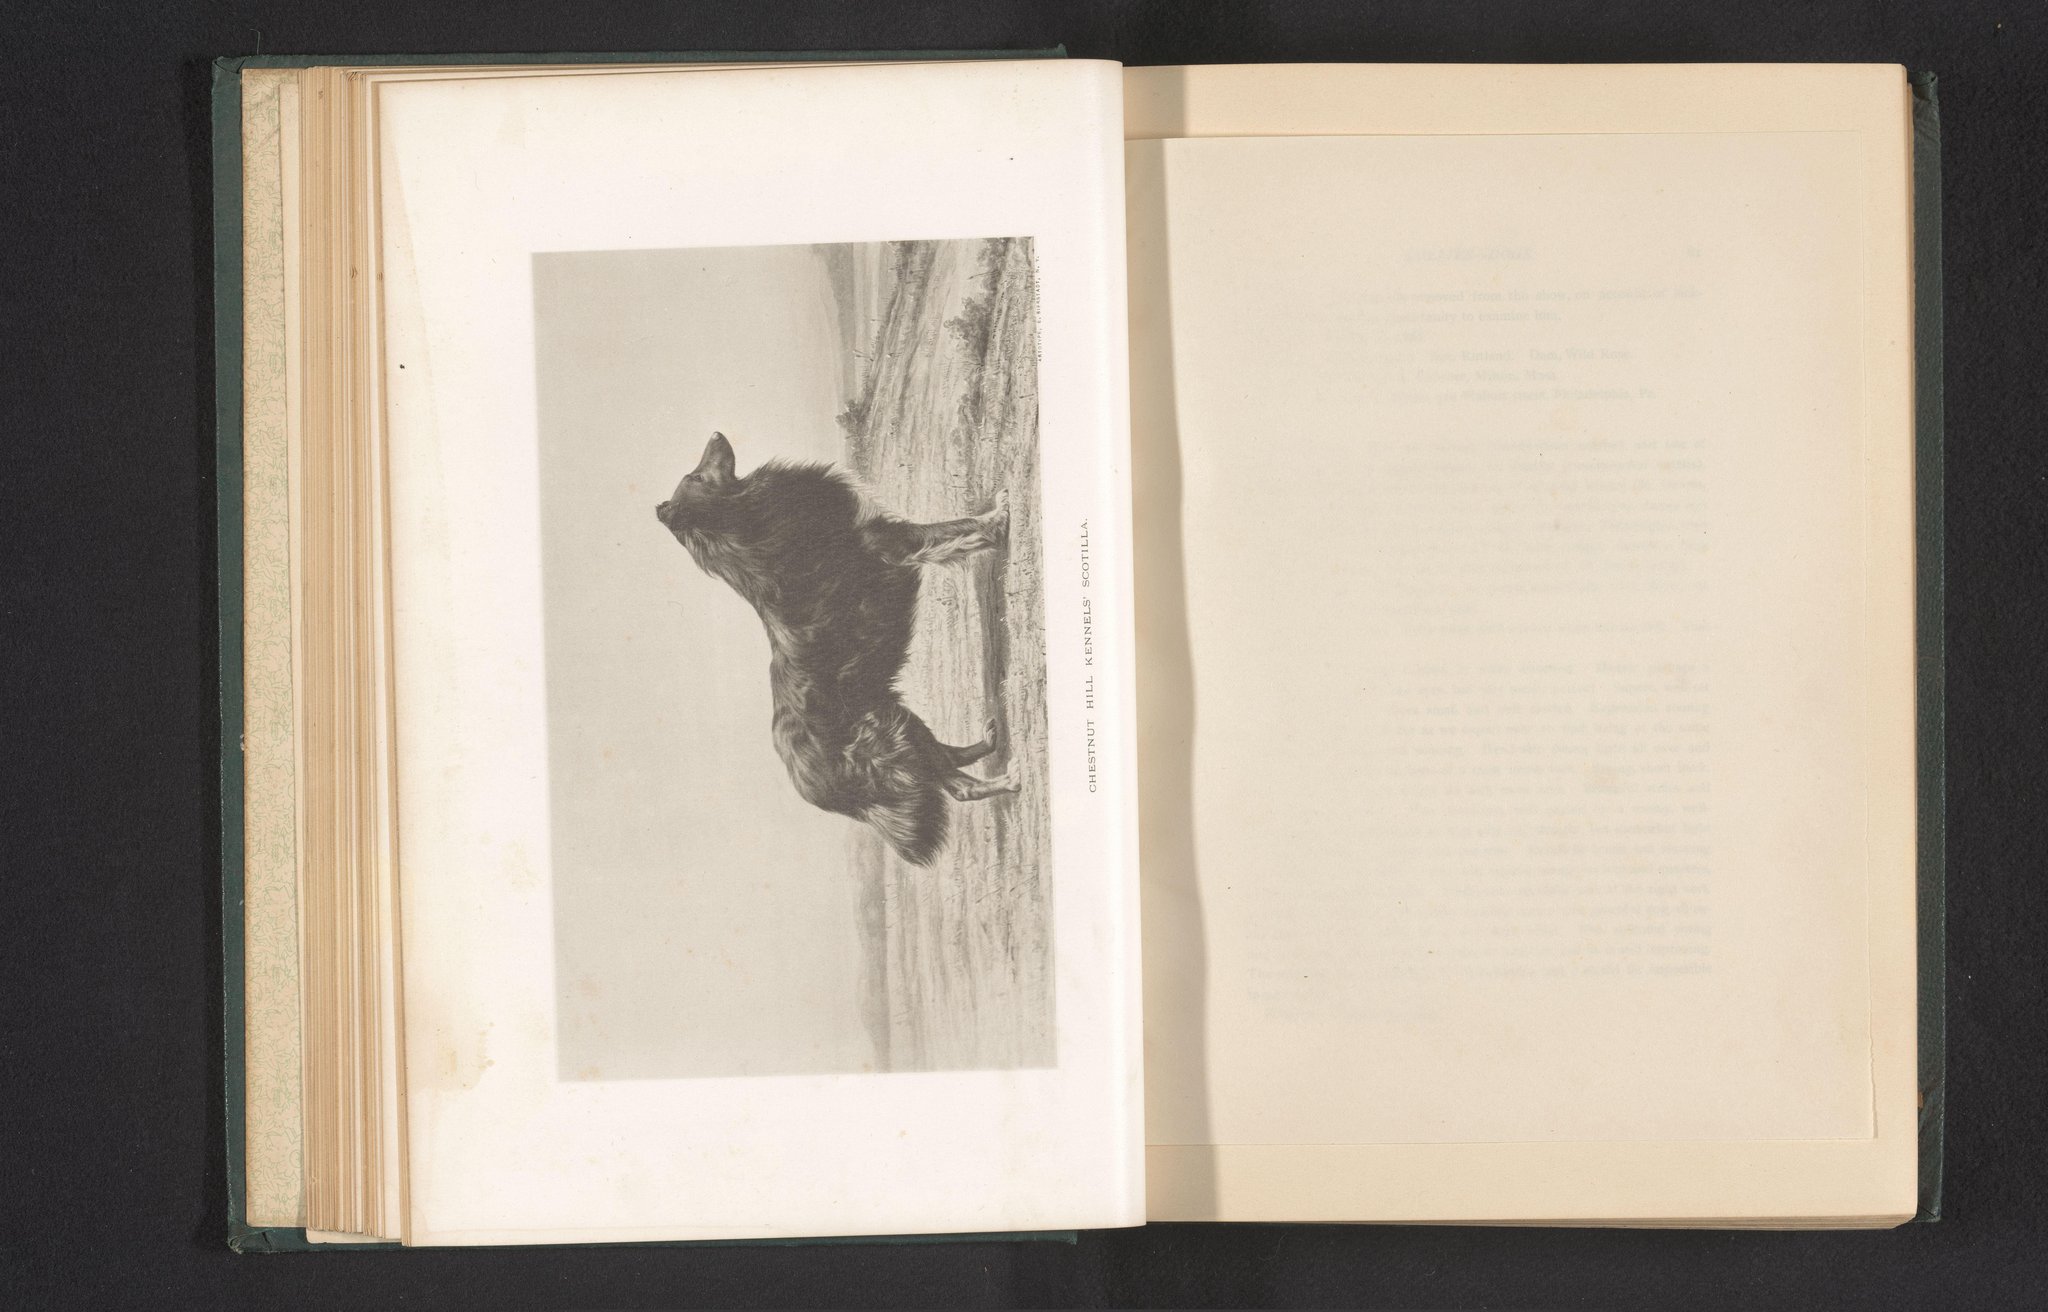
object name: reproduction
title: Reproductie van een schilderij van een collie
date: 1883-1888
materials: paper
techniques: photograph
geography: new york city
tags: dog (with name of kind)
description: Prent tegenover pagina 61, achter semi-transparante omslag.